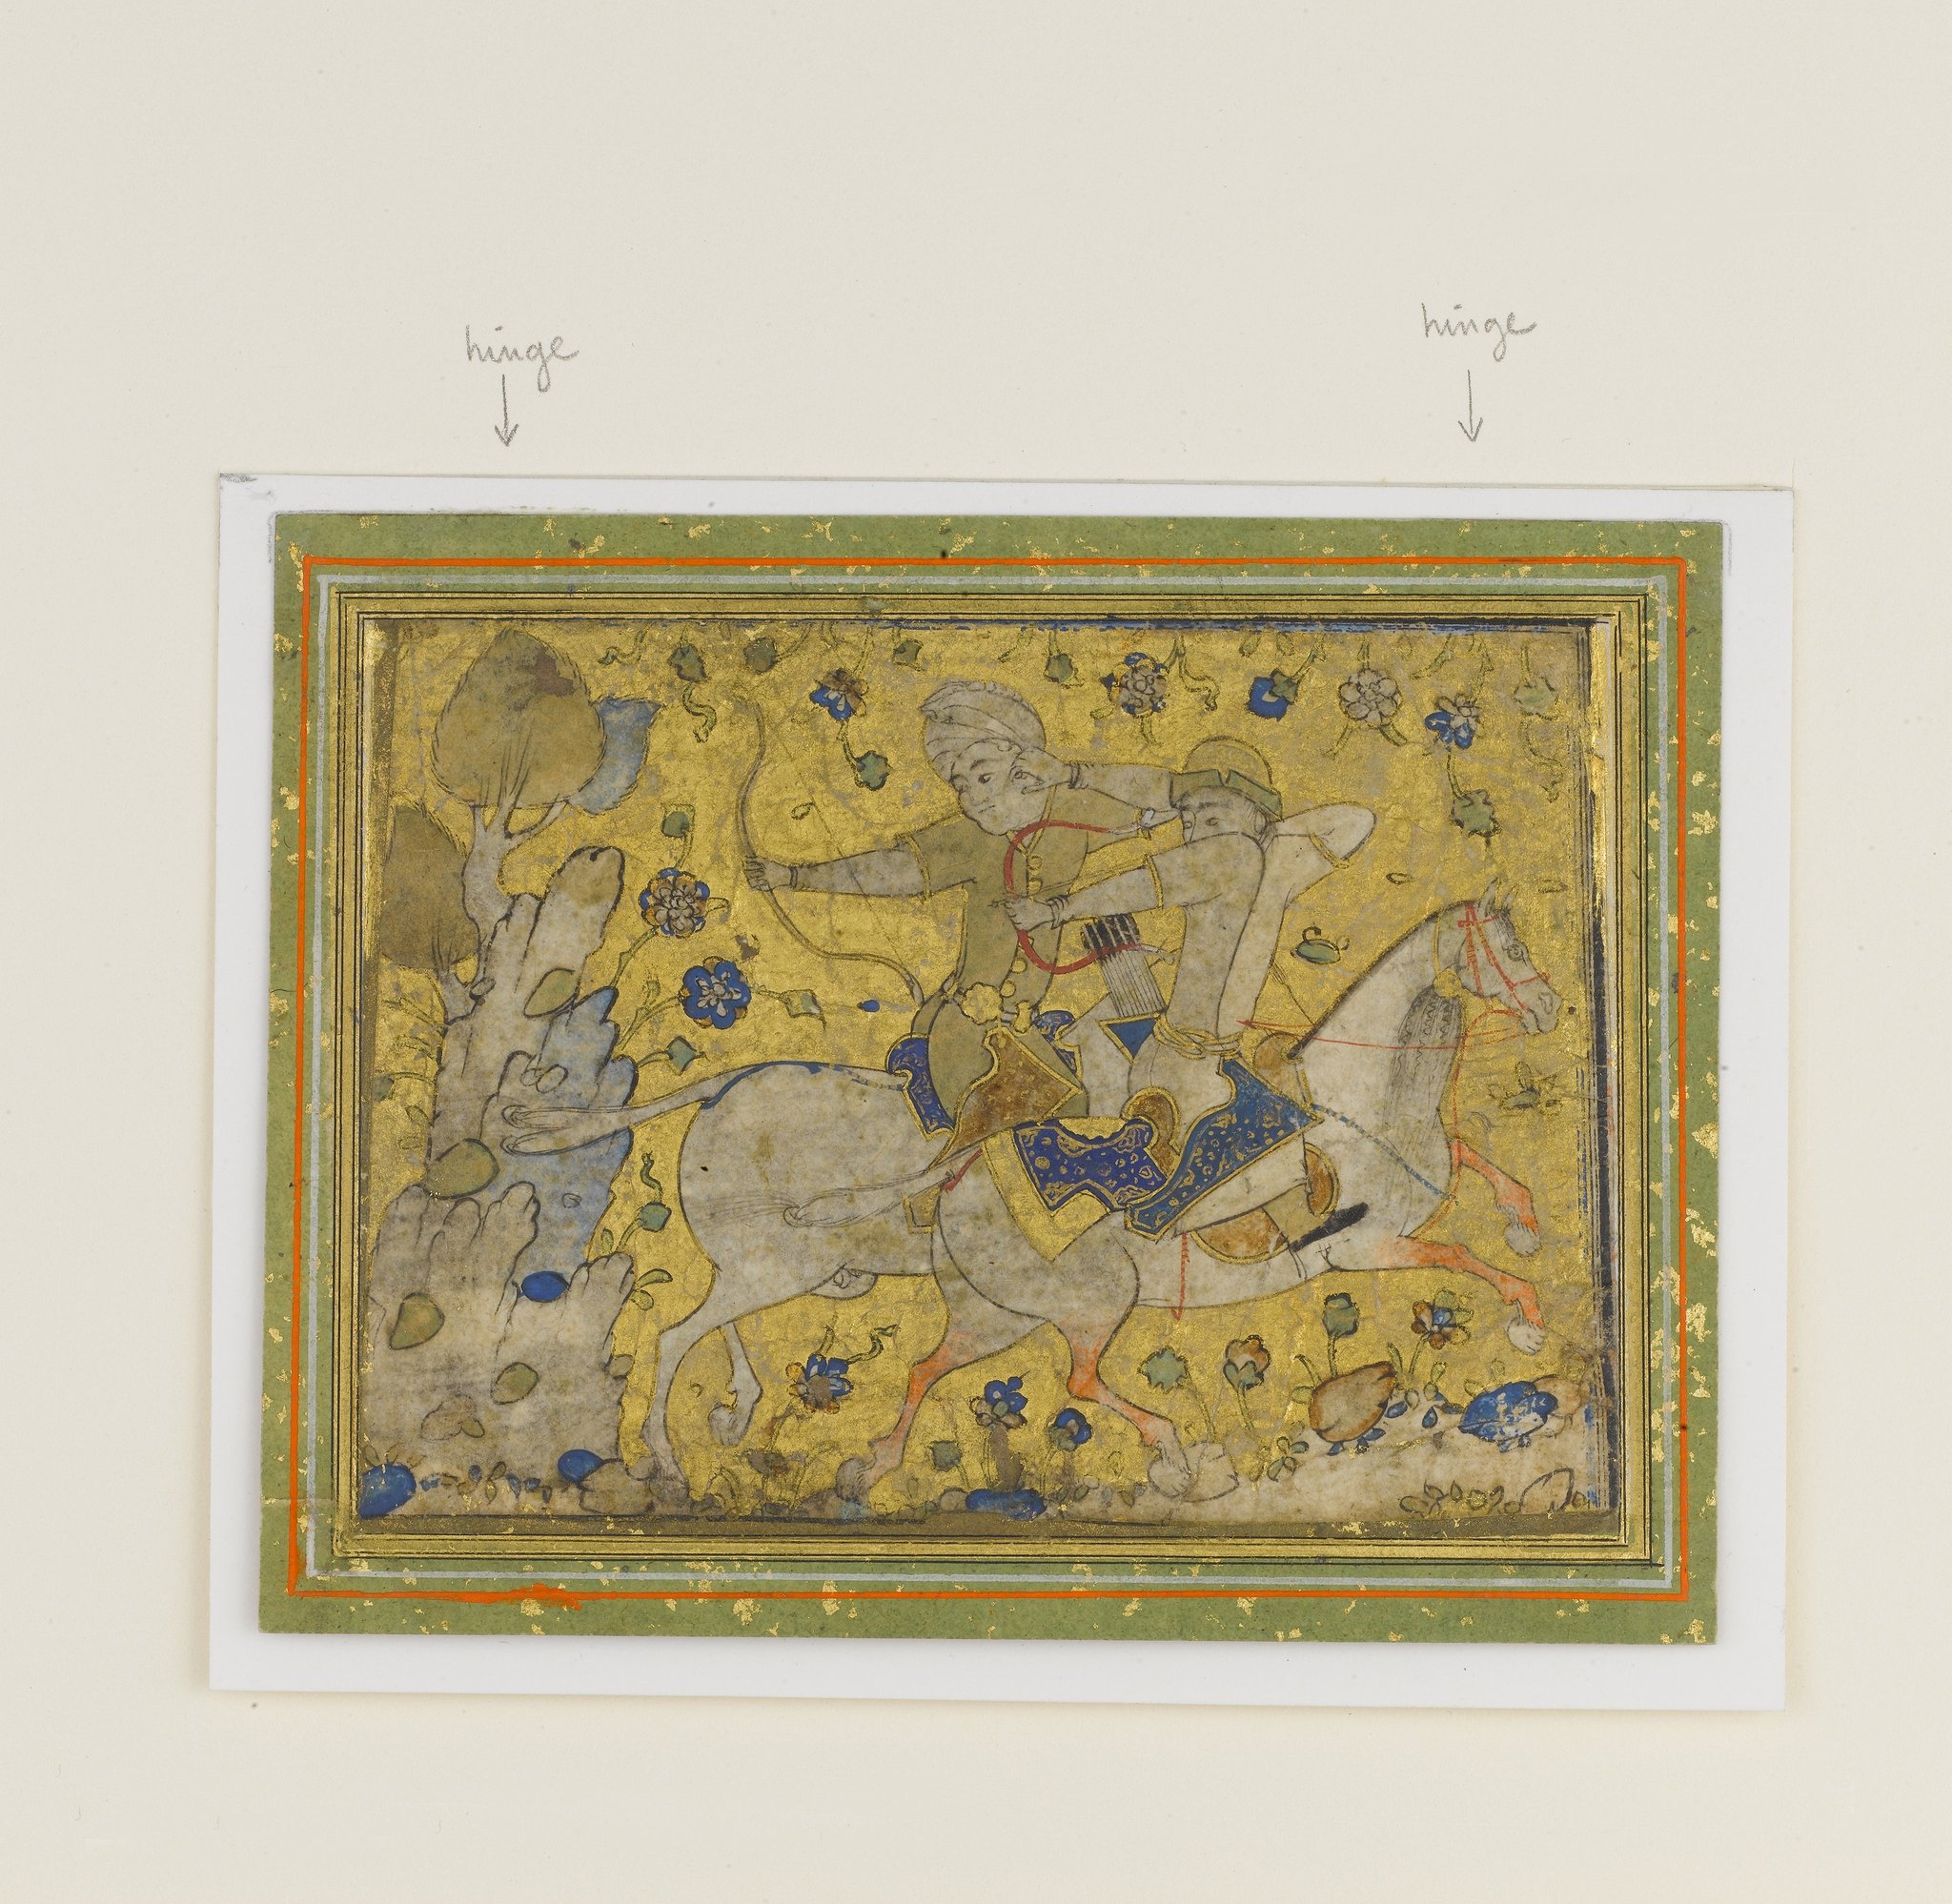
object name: illustrated single work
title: Two Mounted Warriors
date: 1534-1566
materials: gold, ink, paper, watercolor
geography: iran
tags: bow and arrow,men,horses,flowers